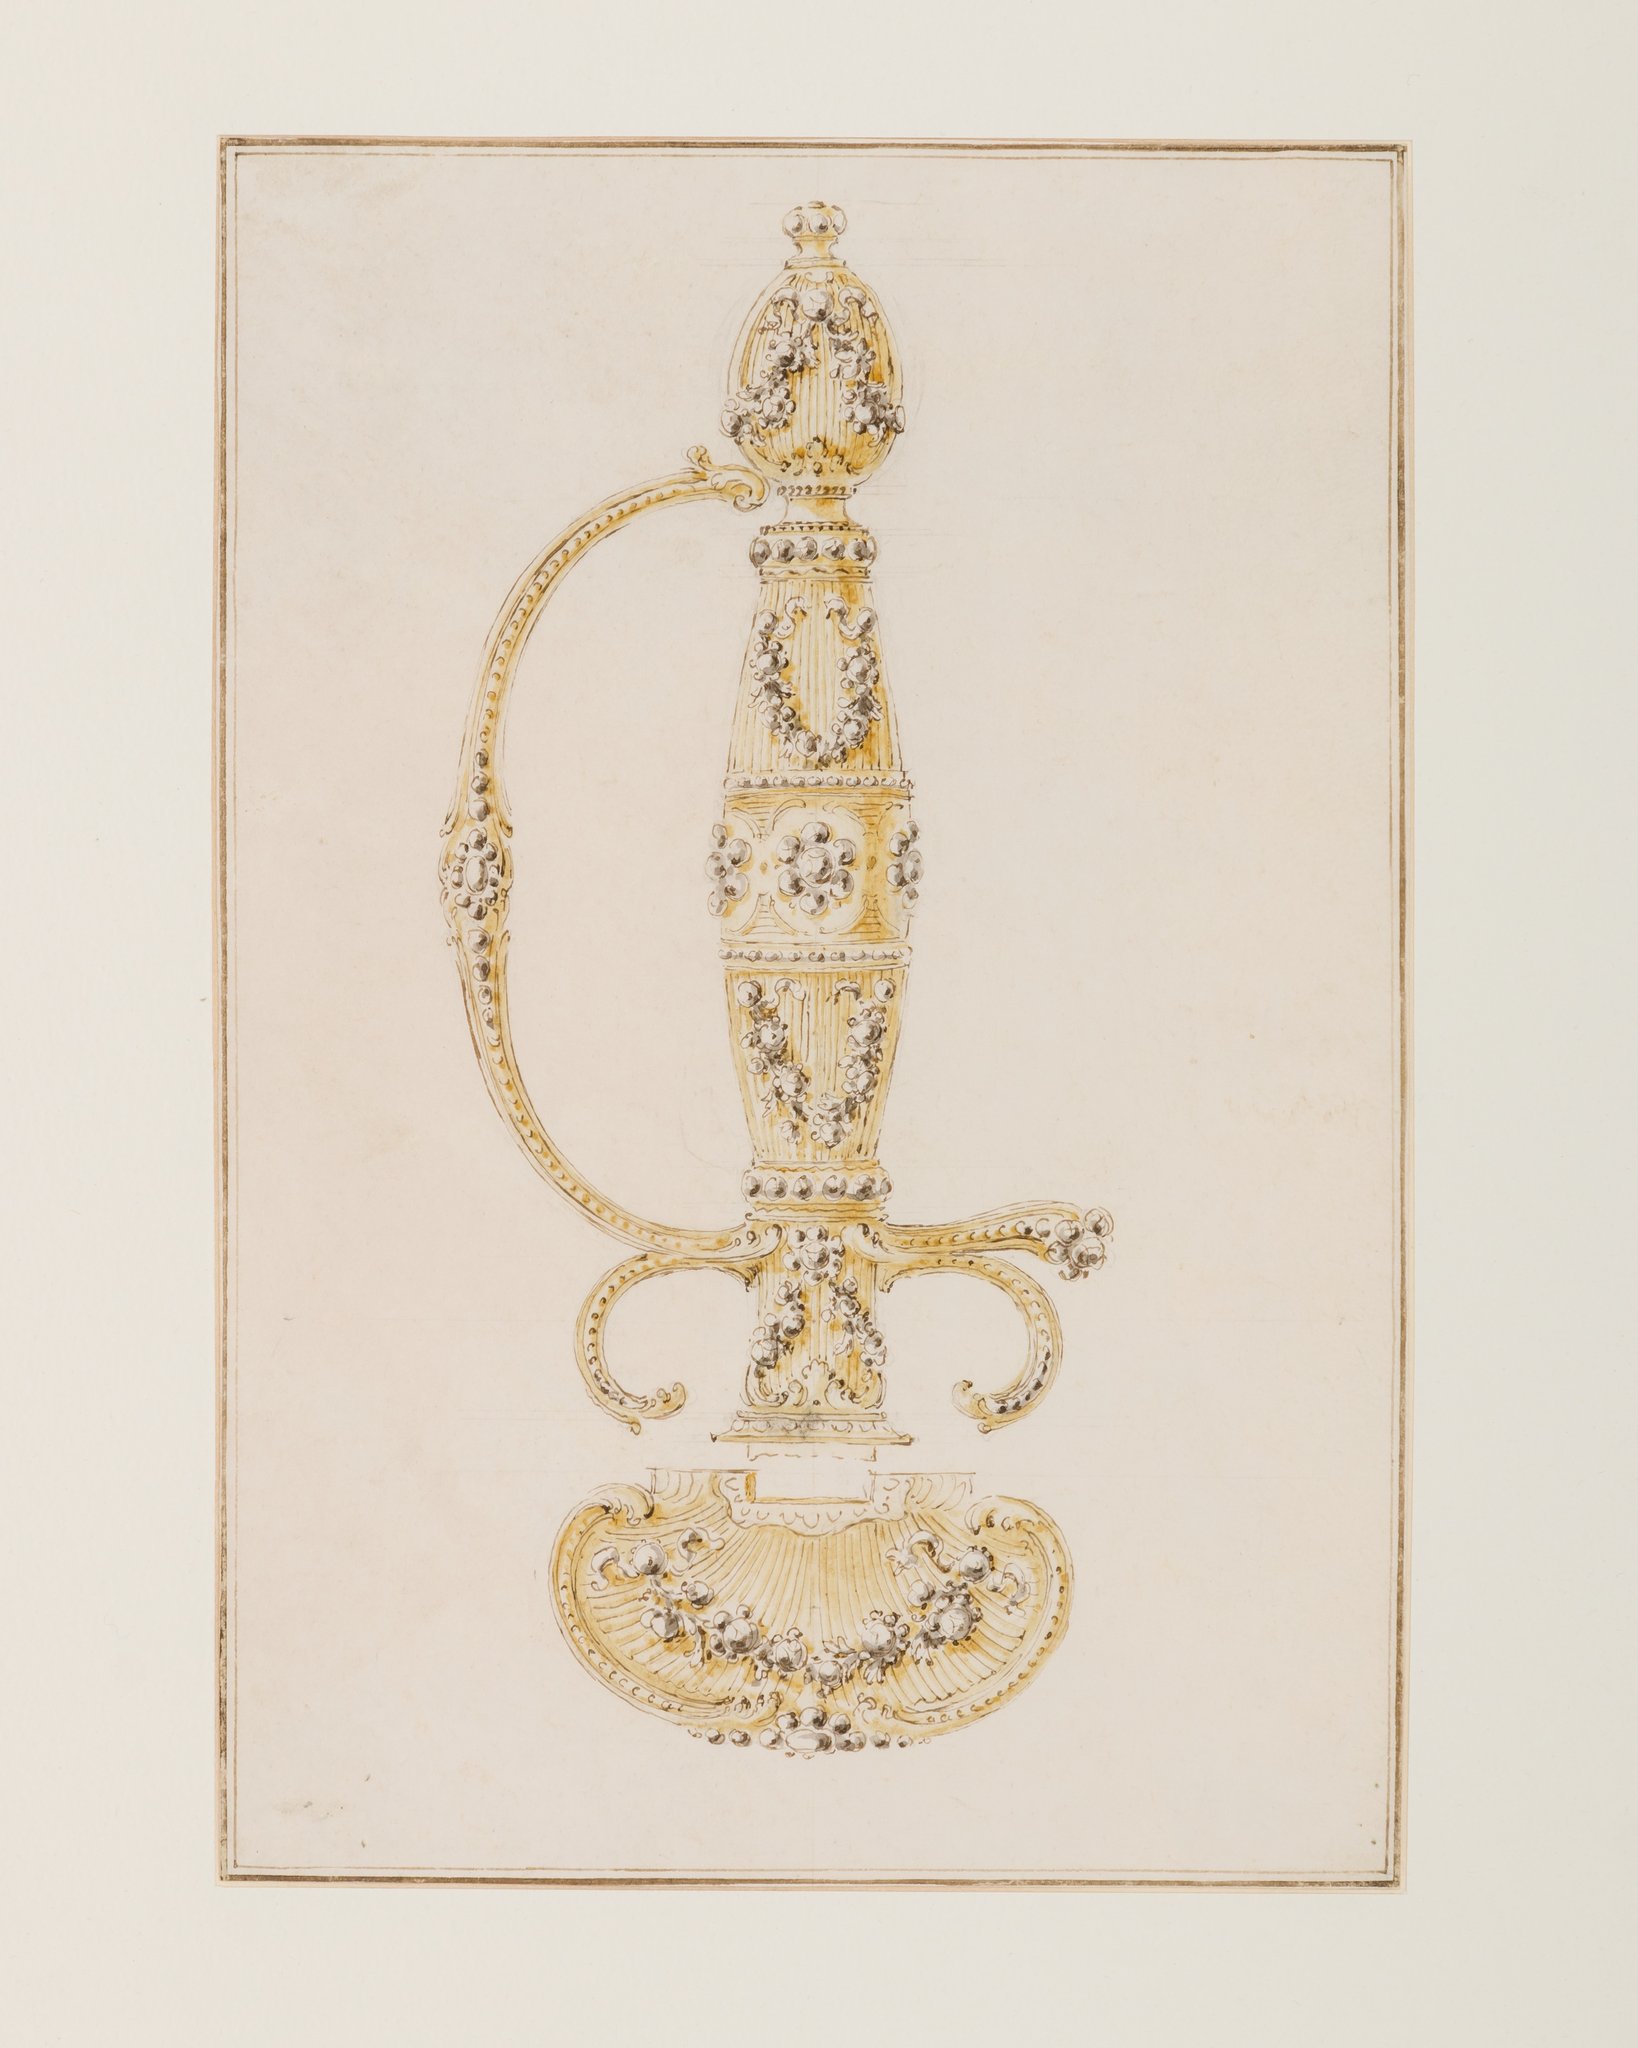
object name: drawing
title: Design for the Hilt of a Small-Sword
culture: italian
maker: luigi valadier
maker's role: artist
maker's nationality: italian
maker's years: 1726-1785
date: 1780-1790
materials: graphite, ink, parchment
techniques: pen, wash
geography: italy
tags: hilts